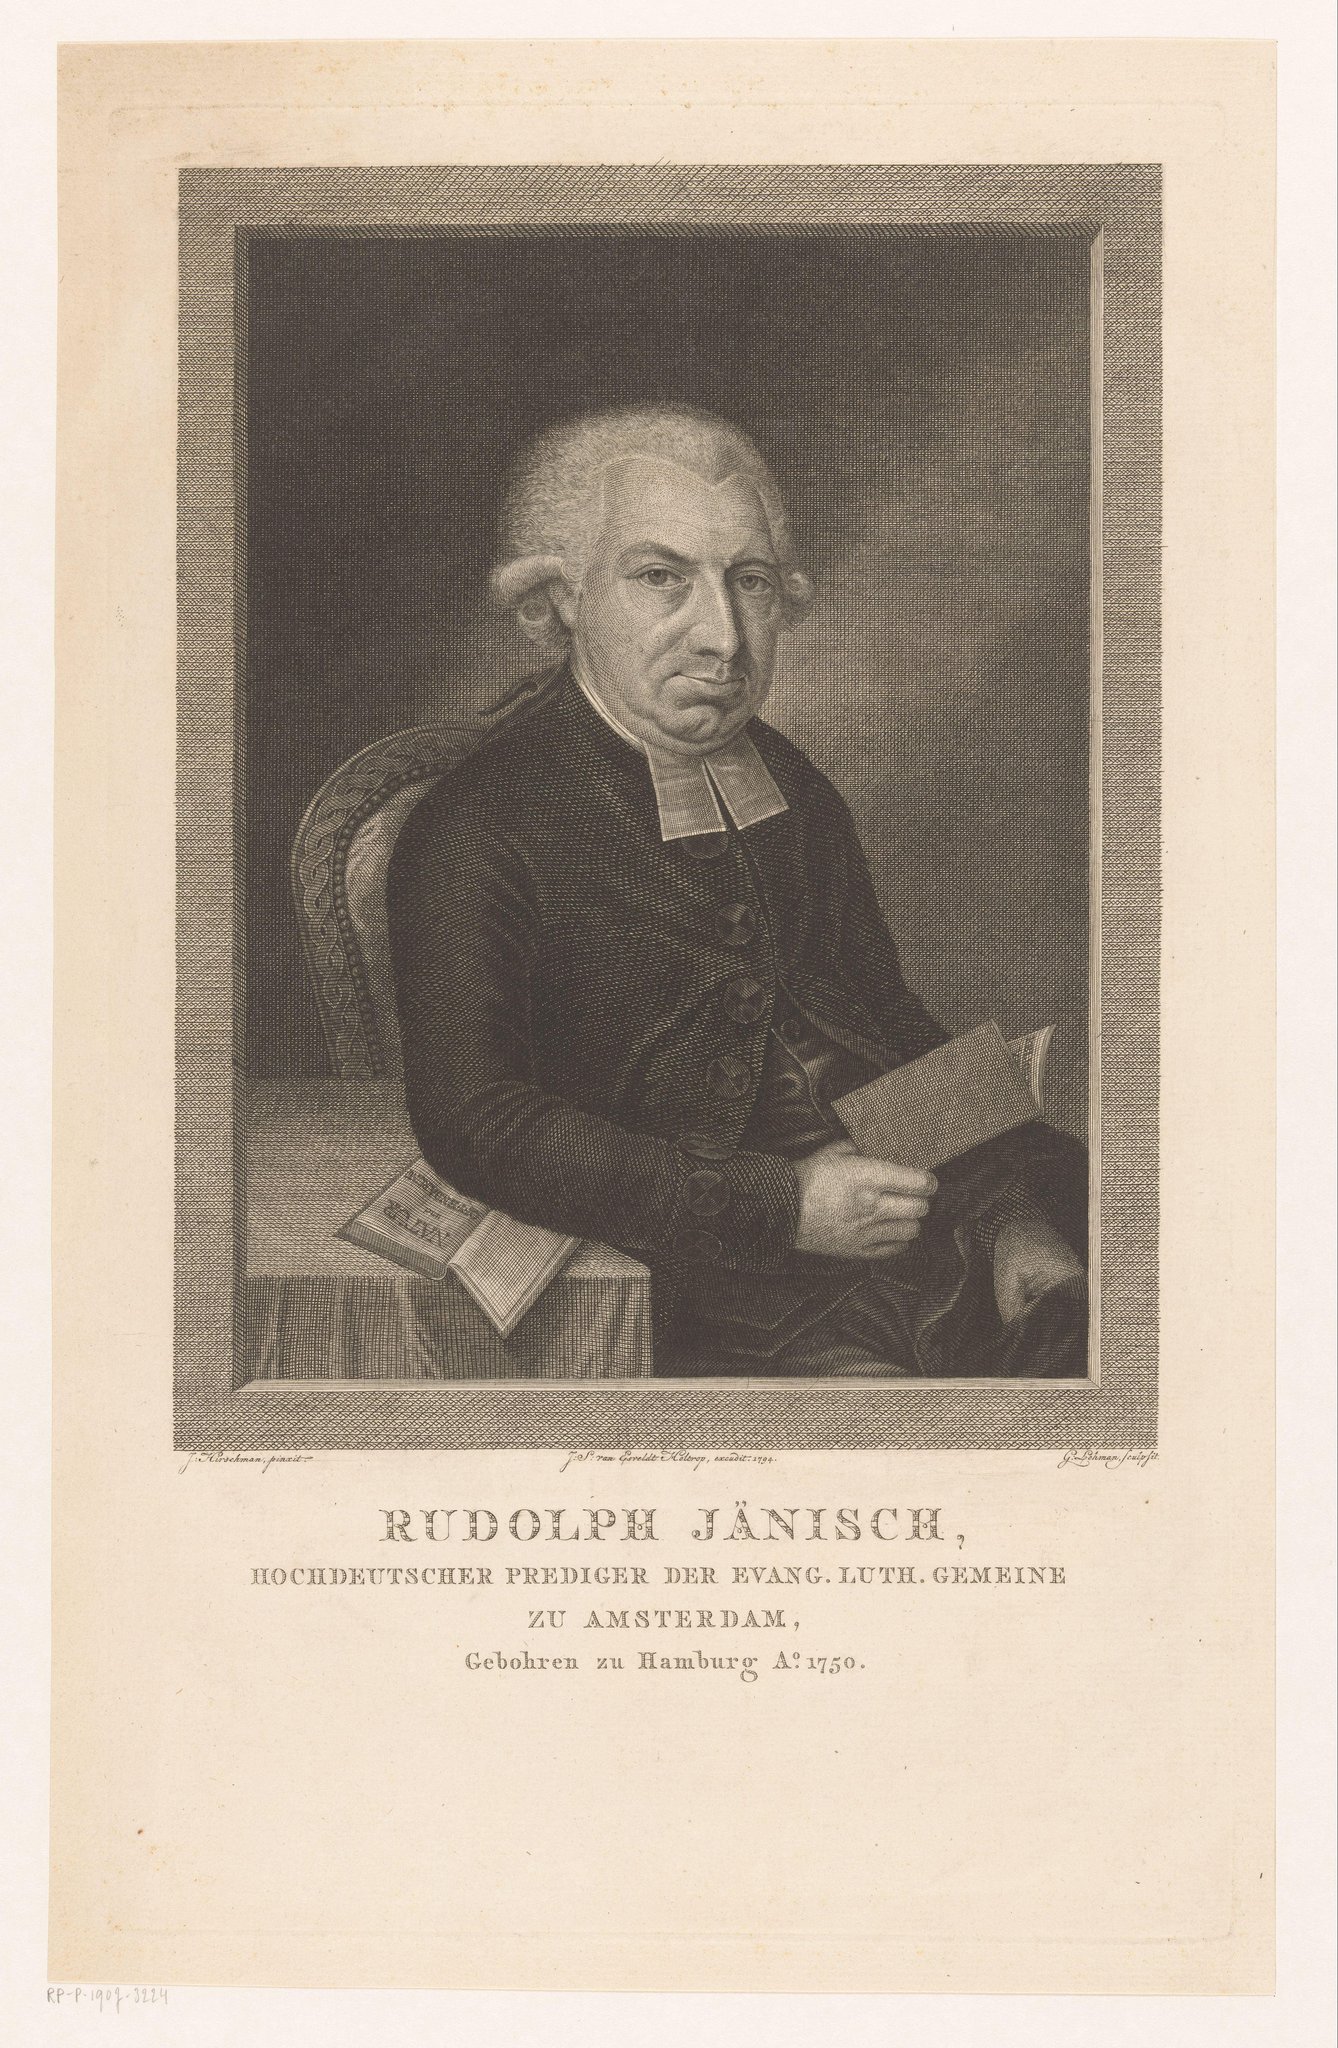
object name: print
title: Portret van Rudolph Jänisch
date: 1794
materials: paper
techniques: engraving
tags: historical persons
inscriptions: collector's mark: Lugt 2228